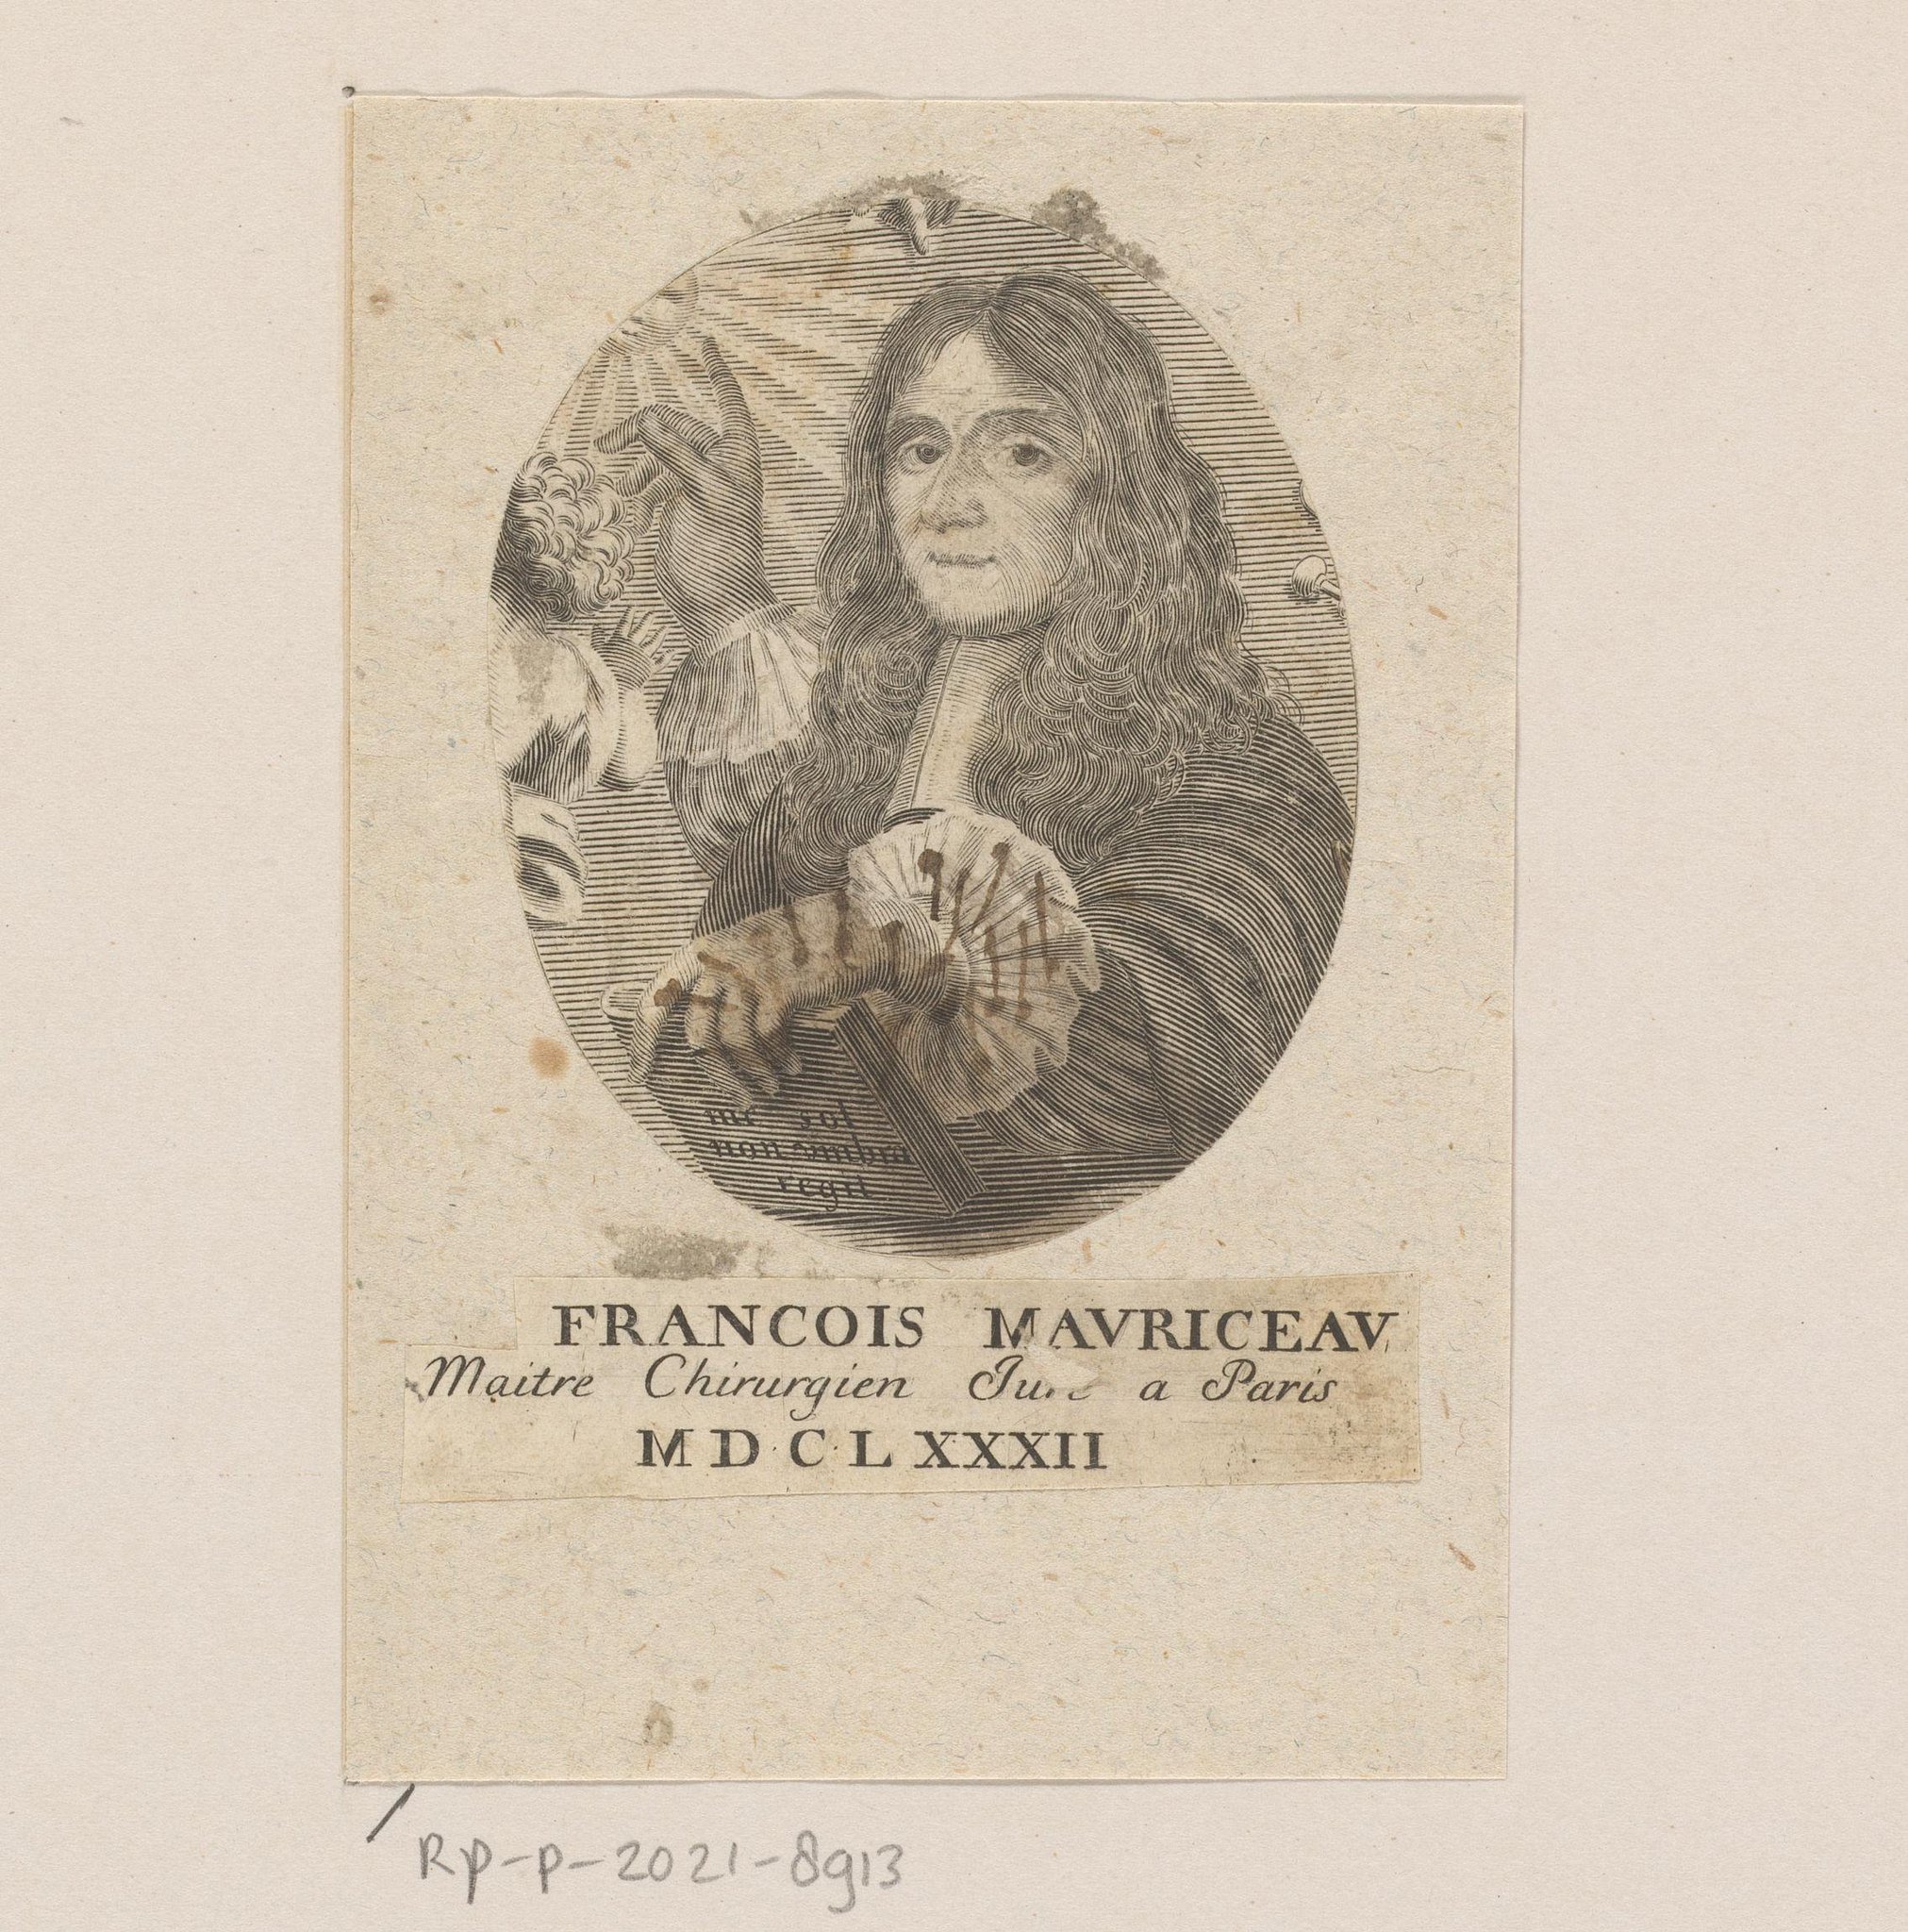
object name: print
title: Portret van François Mauriceau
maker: Anonymous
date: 1668-1750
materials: paper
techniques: engraving, snipping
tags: paris, historical persons, obstetrician, 'accoucheur', book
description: Het portret is waarschijnlijk geknipt uit de titelpagina van een editie van 'Les Maladies des Femmes Grosses et accouchées (...)', voor het eerst in 1668 in Parijs uitgegeven. Het is niet duidelijk of het onderschrift, dat onder het portret is geplakt, uit dezelfde prent afkomstig is.